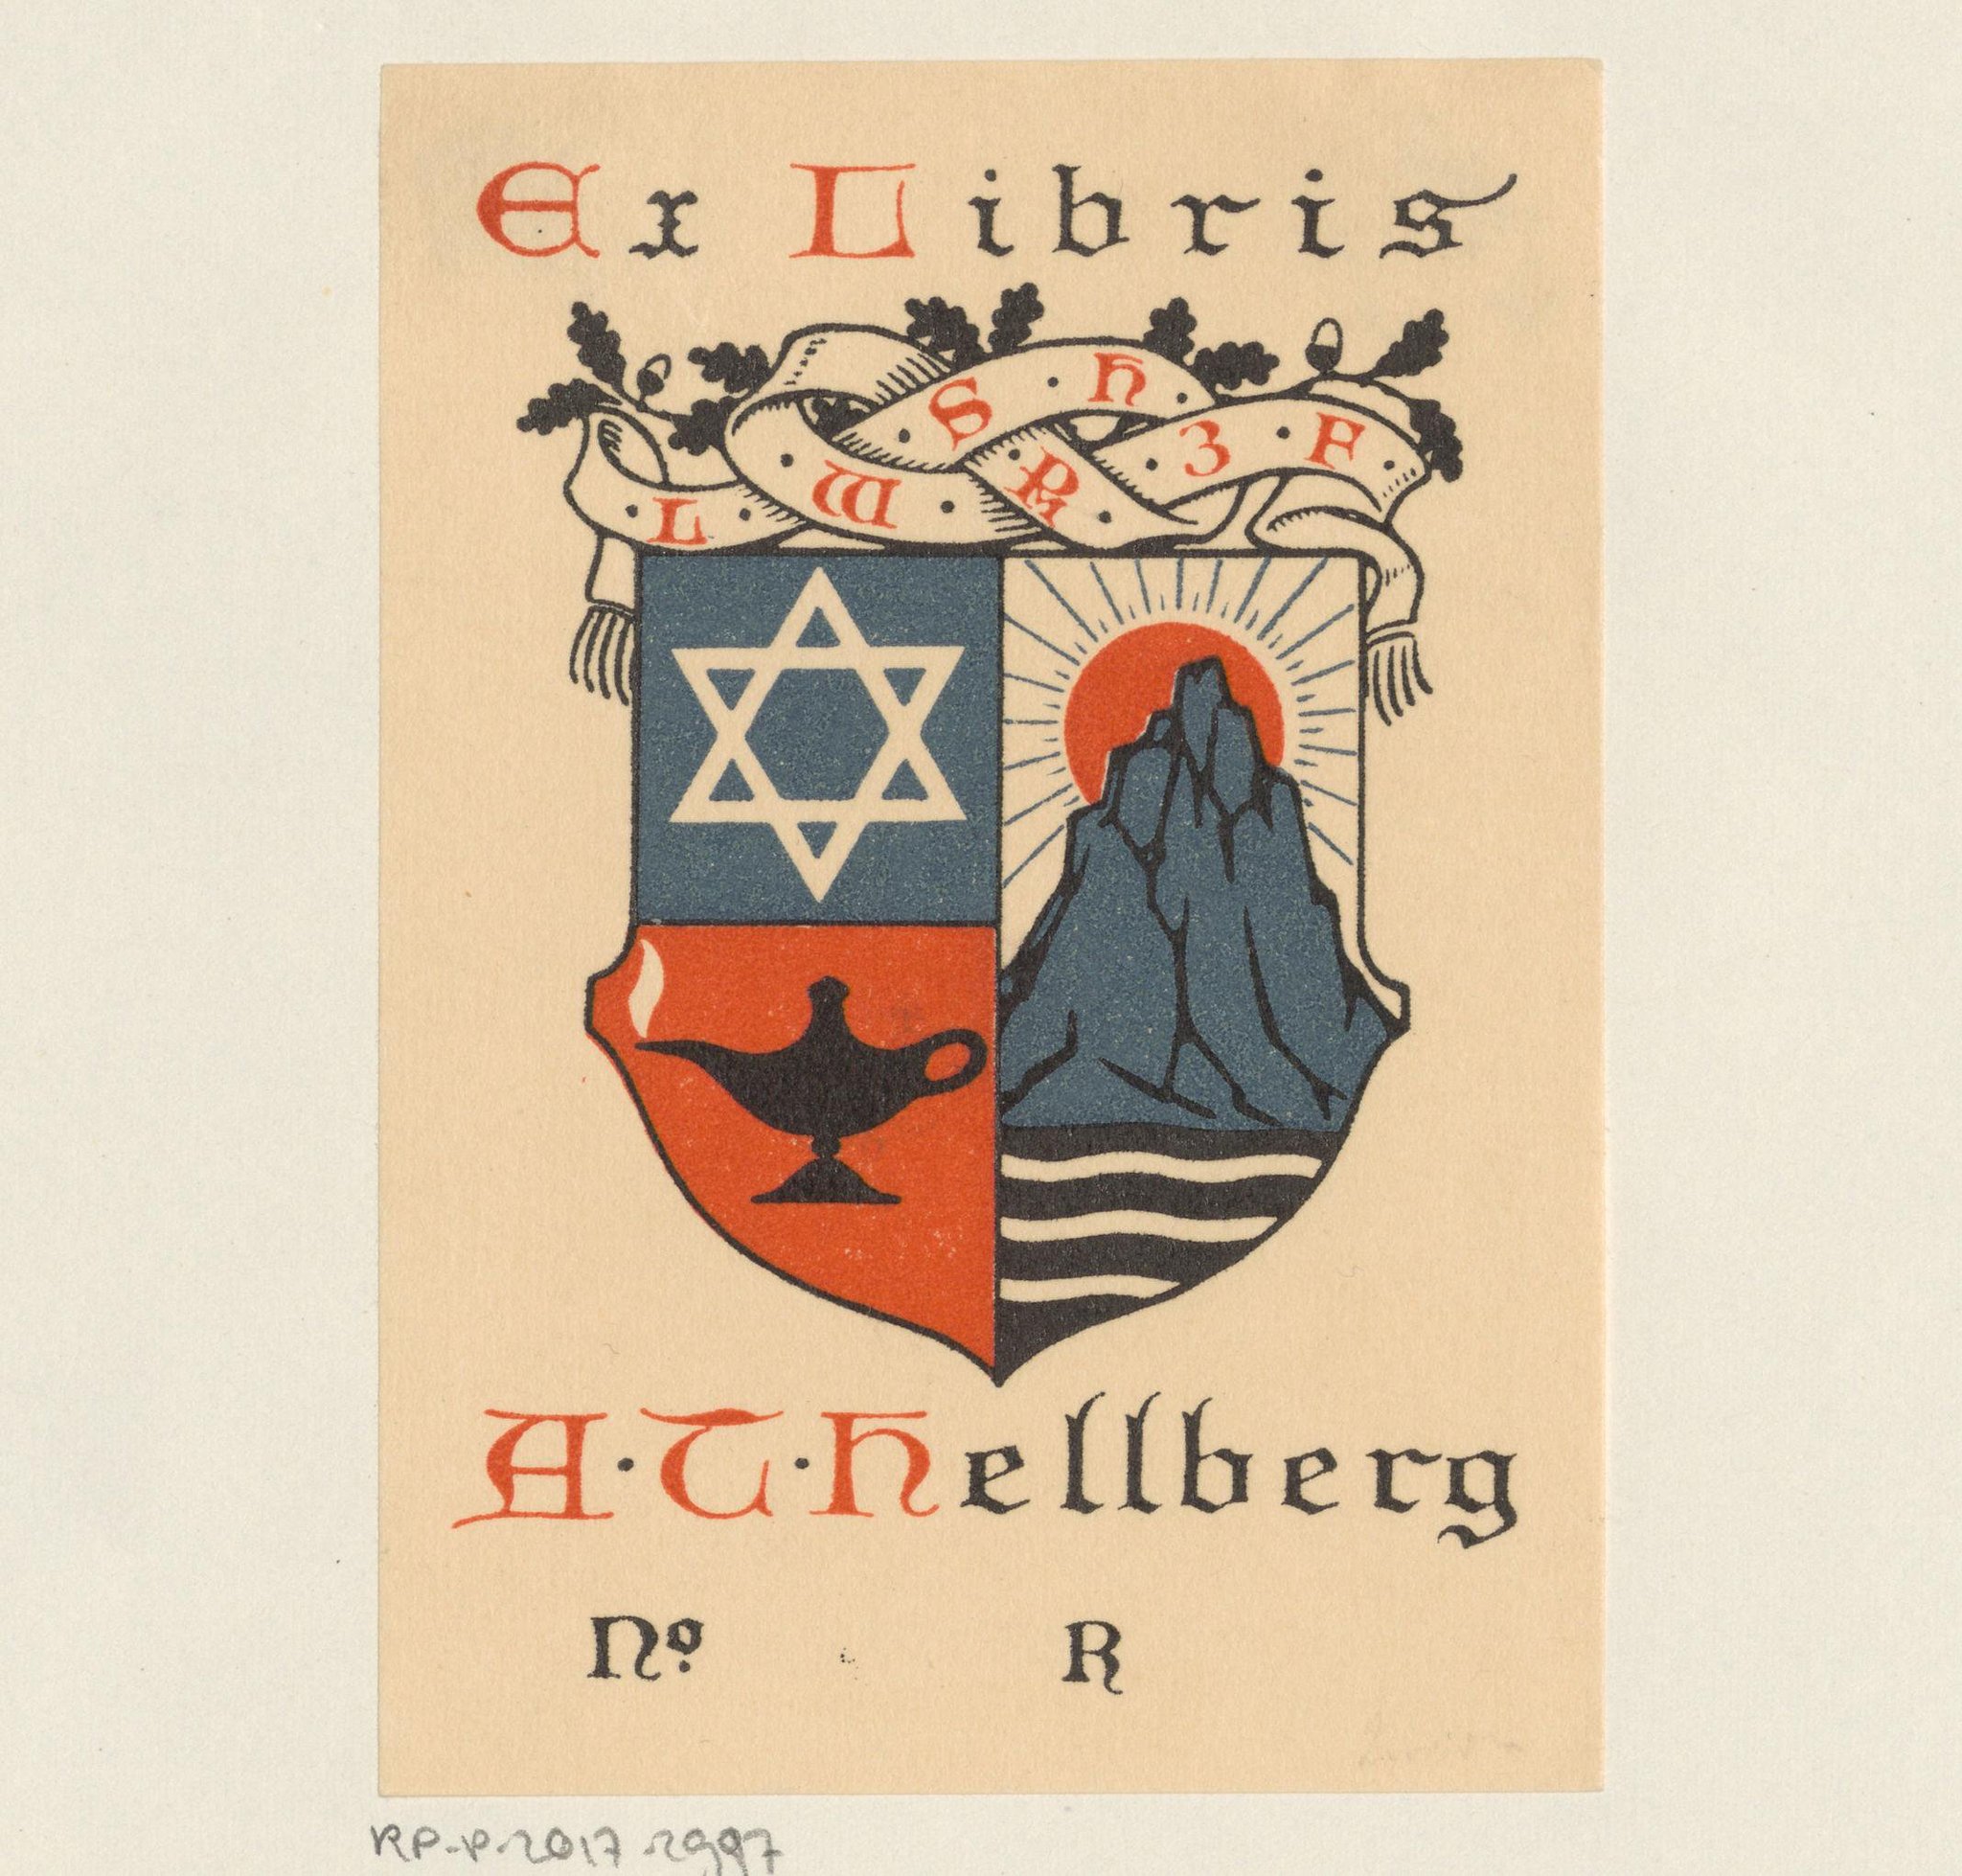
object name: bookplate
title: Ex libris van A.T. Hellberg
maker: Anonymous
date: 1900-1999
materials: paper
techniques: printing block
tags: trees: oak, oil-lamp, sun as celestial body, armorial bearing, heraldry, mountains